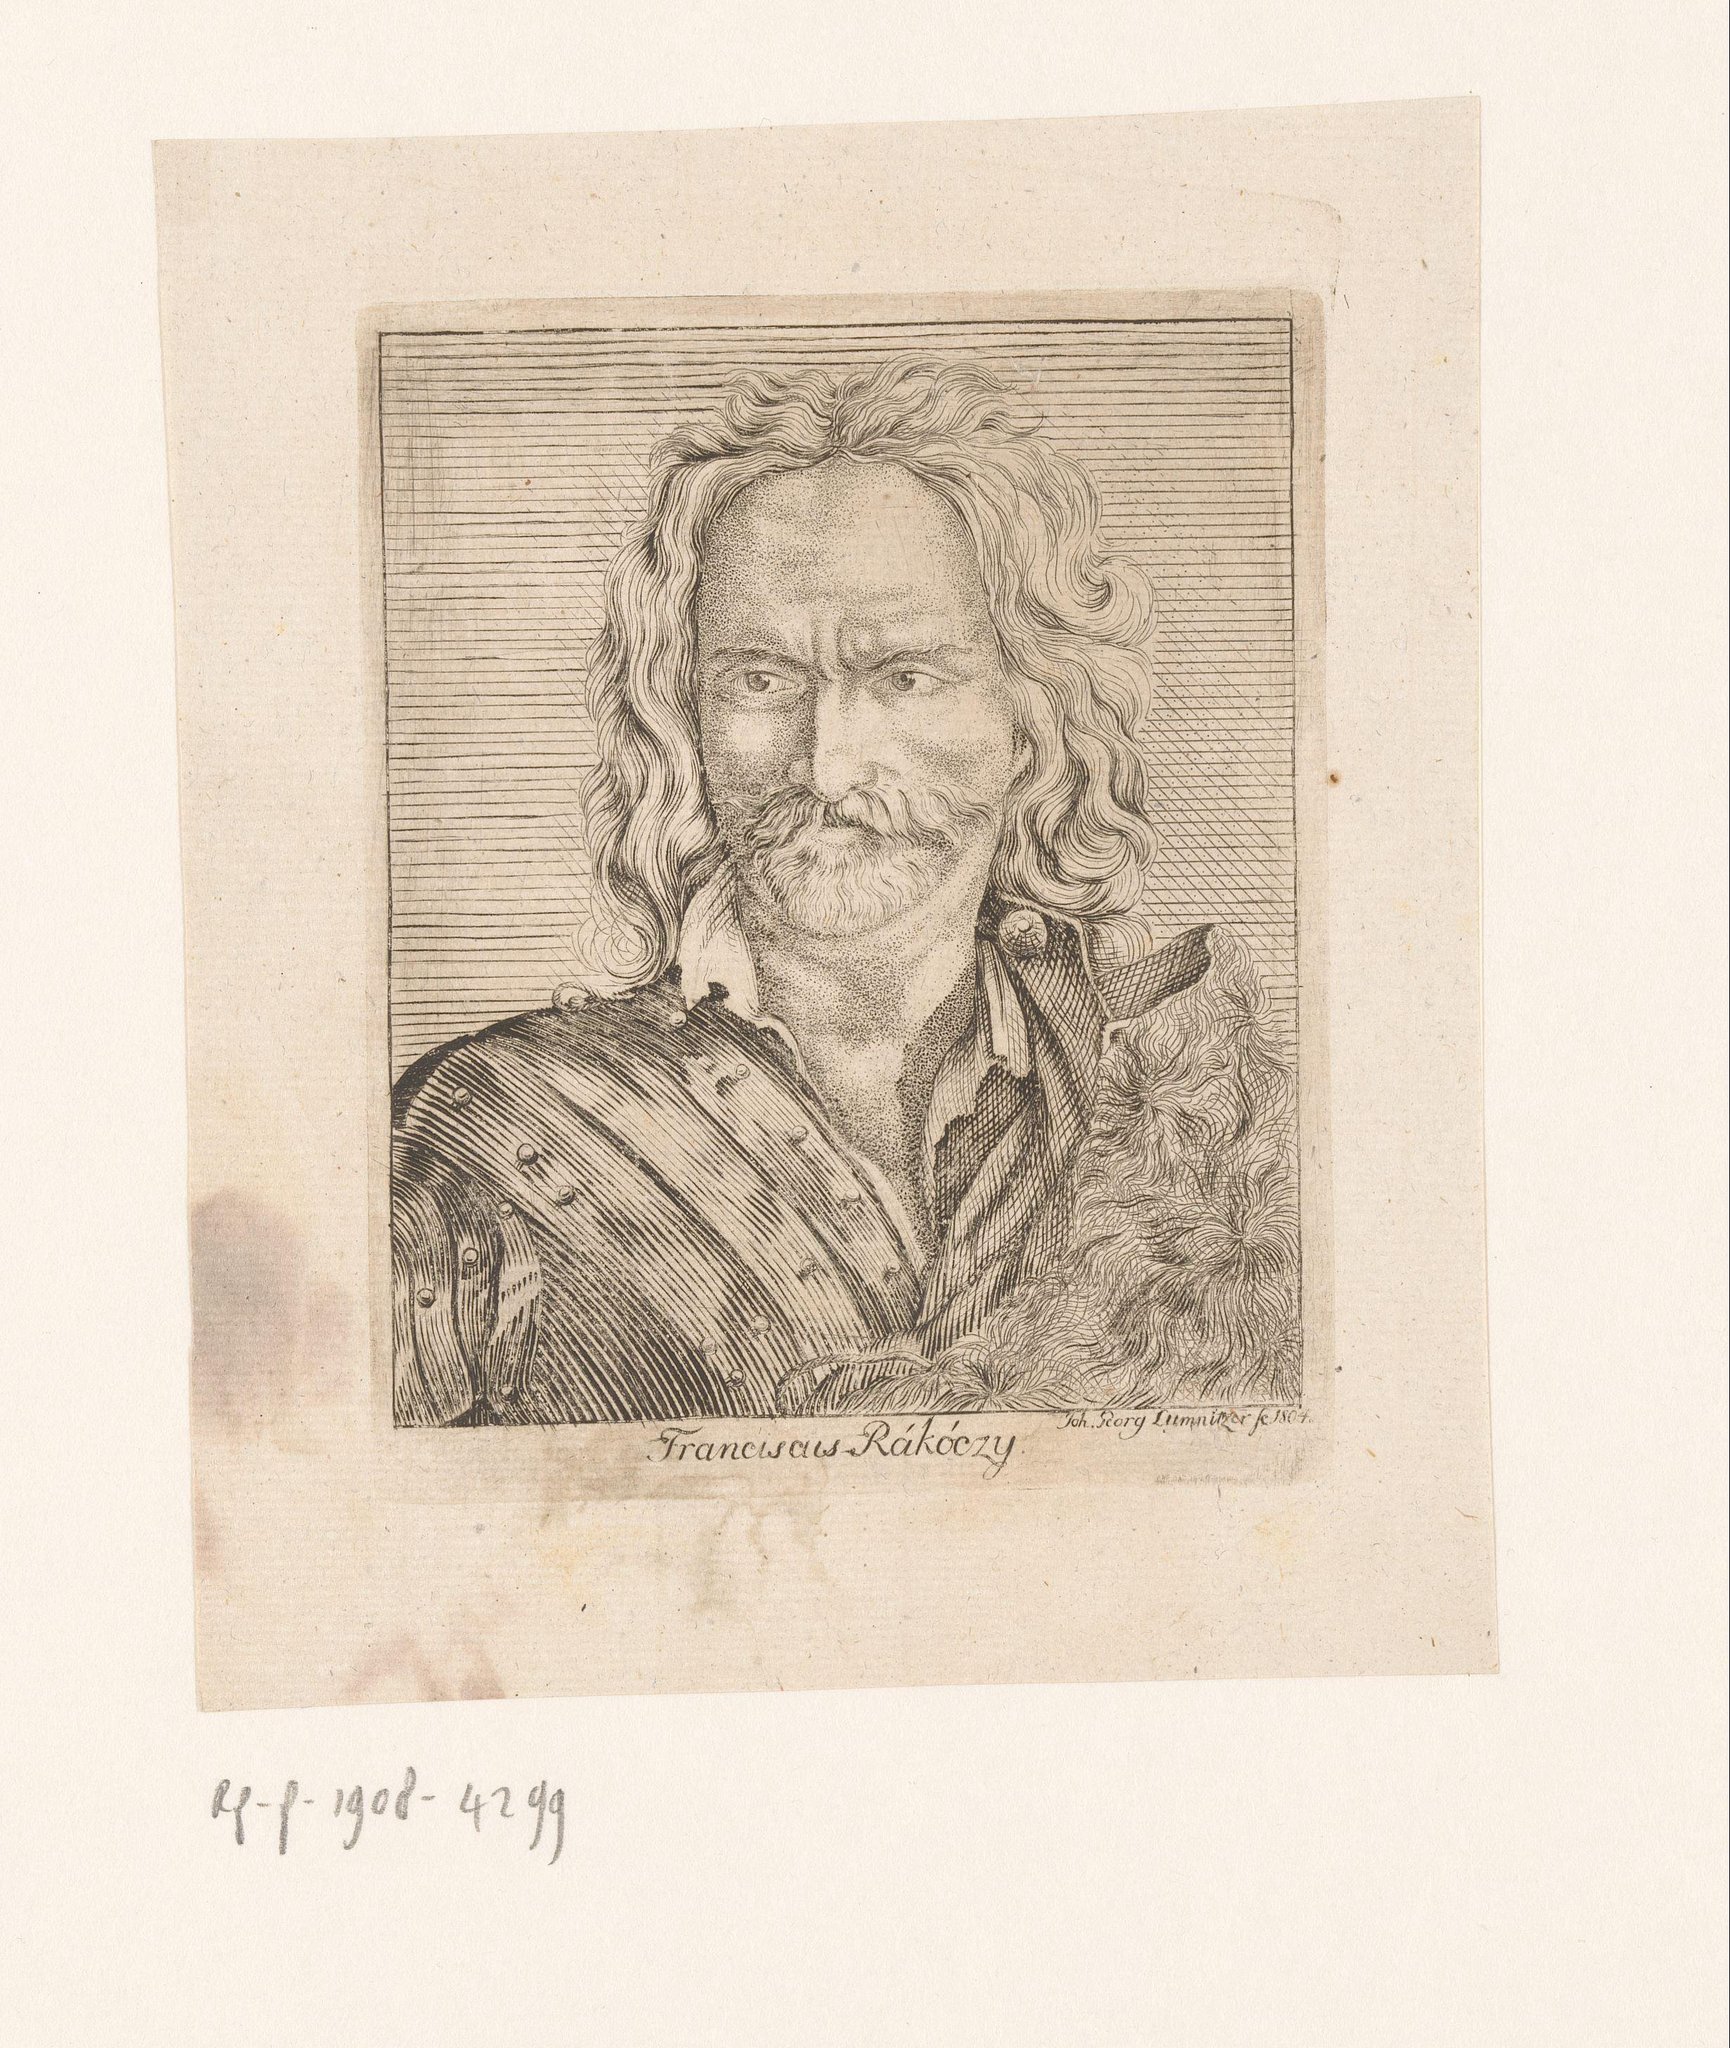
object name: print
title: Portret van Frans II Rákóczi, prins van Transsilvanië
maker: johann georg lumnitzer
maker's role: print maker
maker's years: 1783-1864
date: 1804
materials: paper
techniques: engraving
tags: armour, historical persons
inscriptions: collector's mark: Lugt 2228